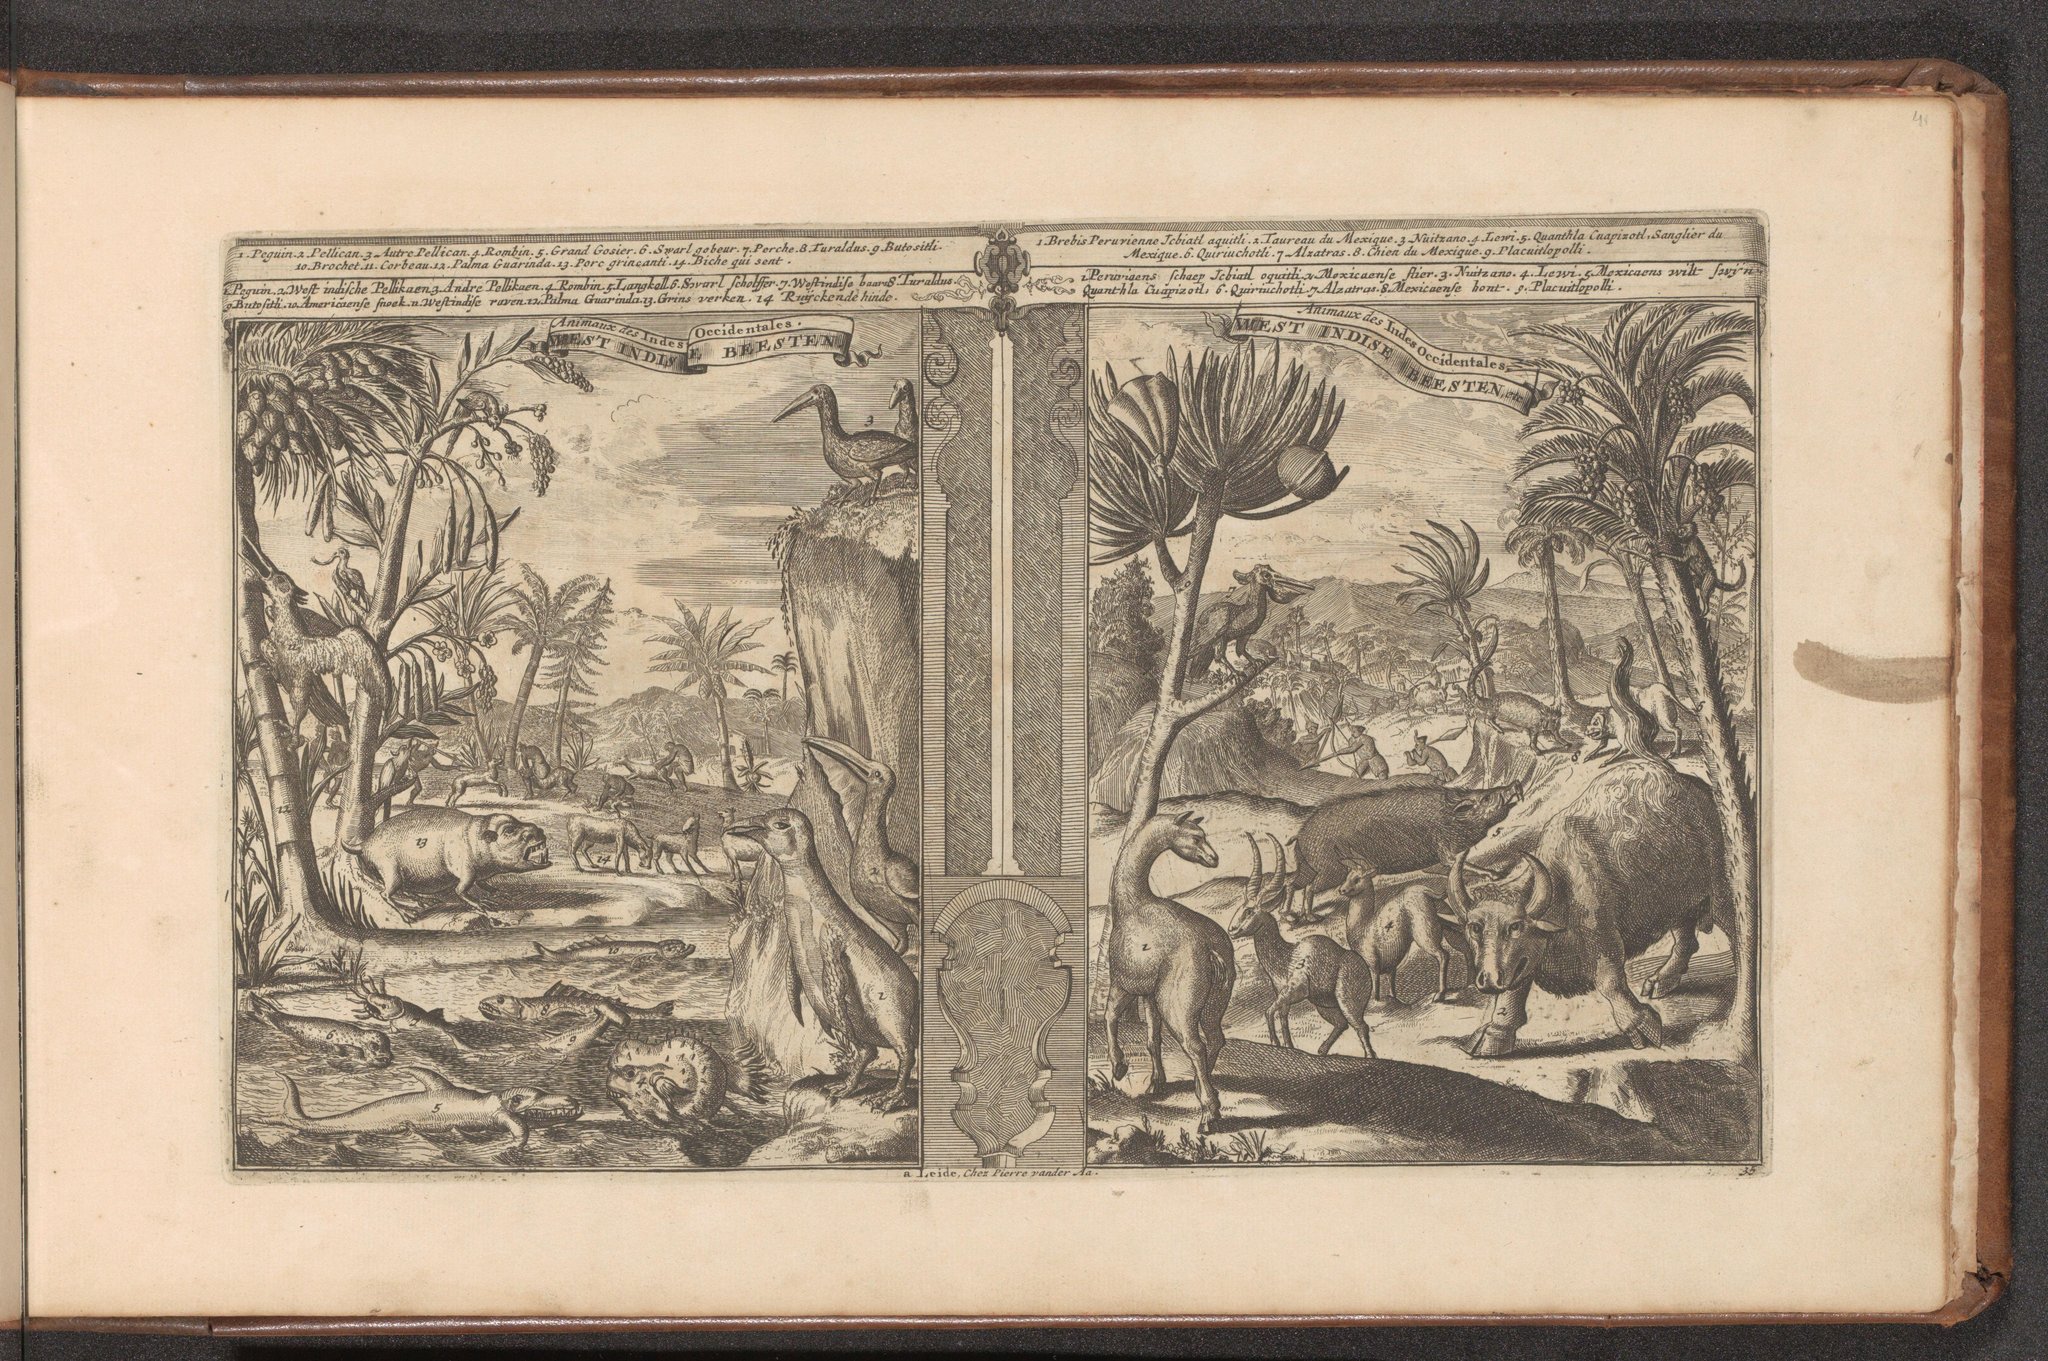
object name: album leaf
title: Les Indes Orientales et Occidentales et autres lieux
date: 1682-1733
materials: paper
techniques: etching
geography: leiden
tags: animals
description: Voorstelling in twee delen. Zowel links als rechts een landschap met dieren uit West-Indië. Links onder meer een pinguin en pelikaan. Op de voorgrond verschillende vissen. Op de rechter voorstelling een Peruaans schaap, een Mexicaanse stier, een Mexicaans wild zwijn en een Mexicaanse hond. Met een legenda in het Nederlands en het Frans. De prent maakt deel uit van een album.